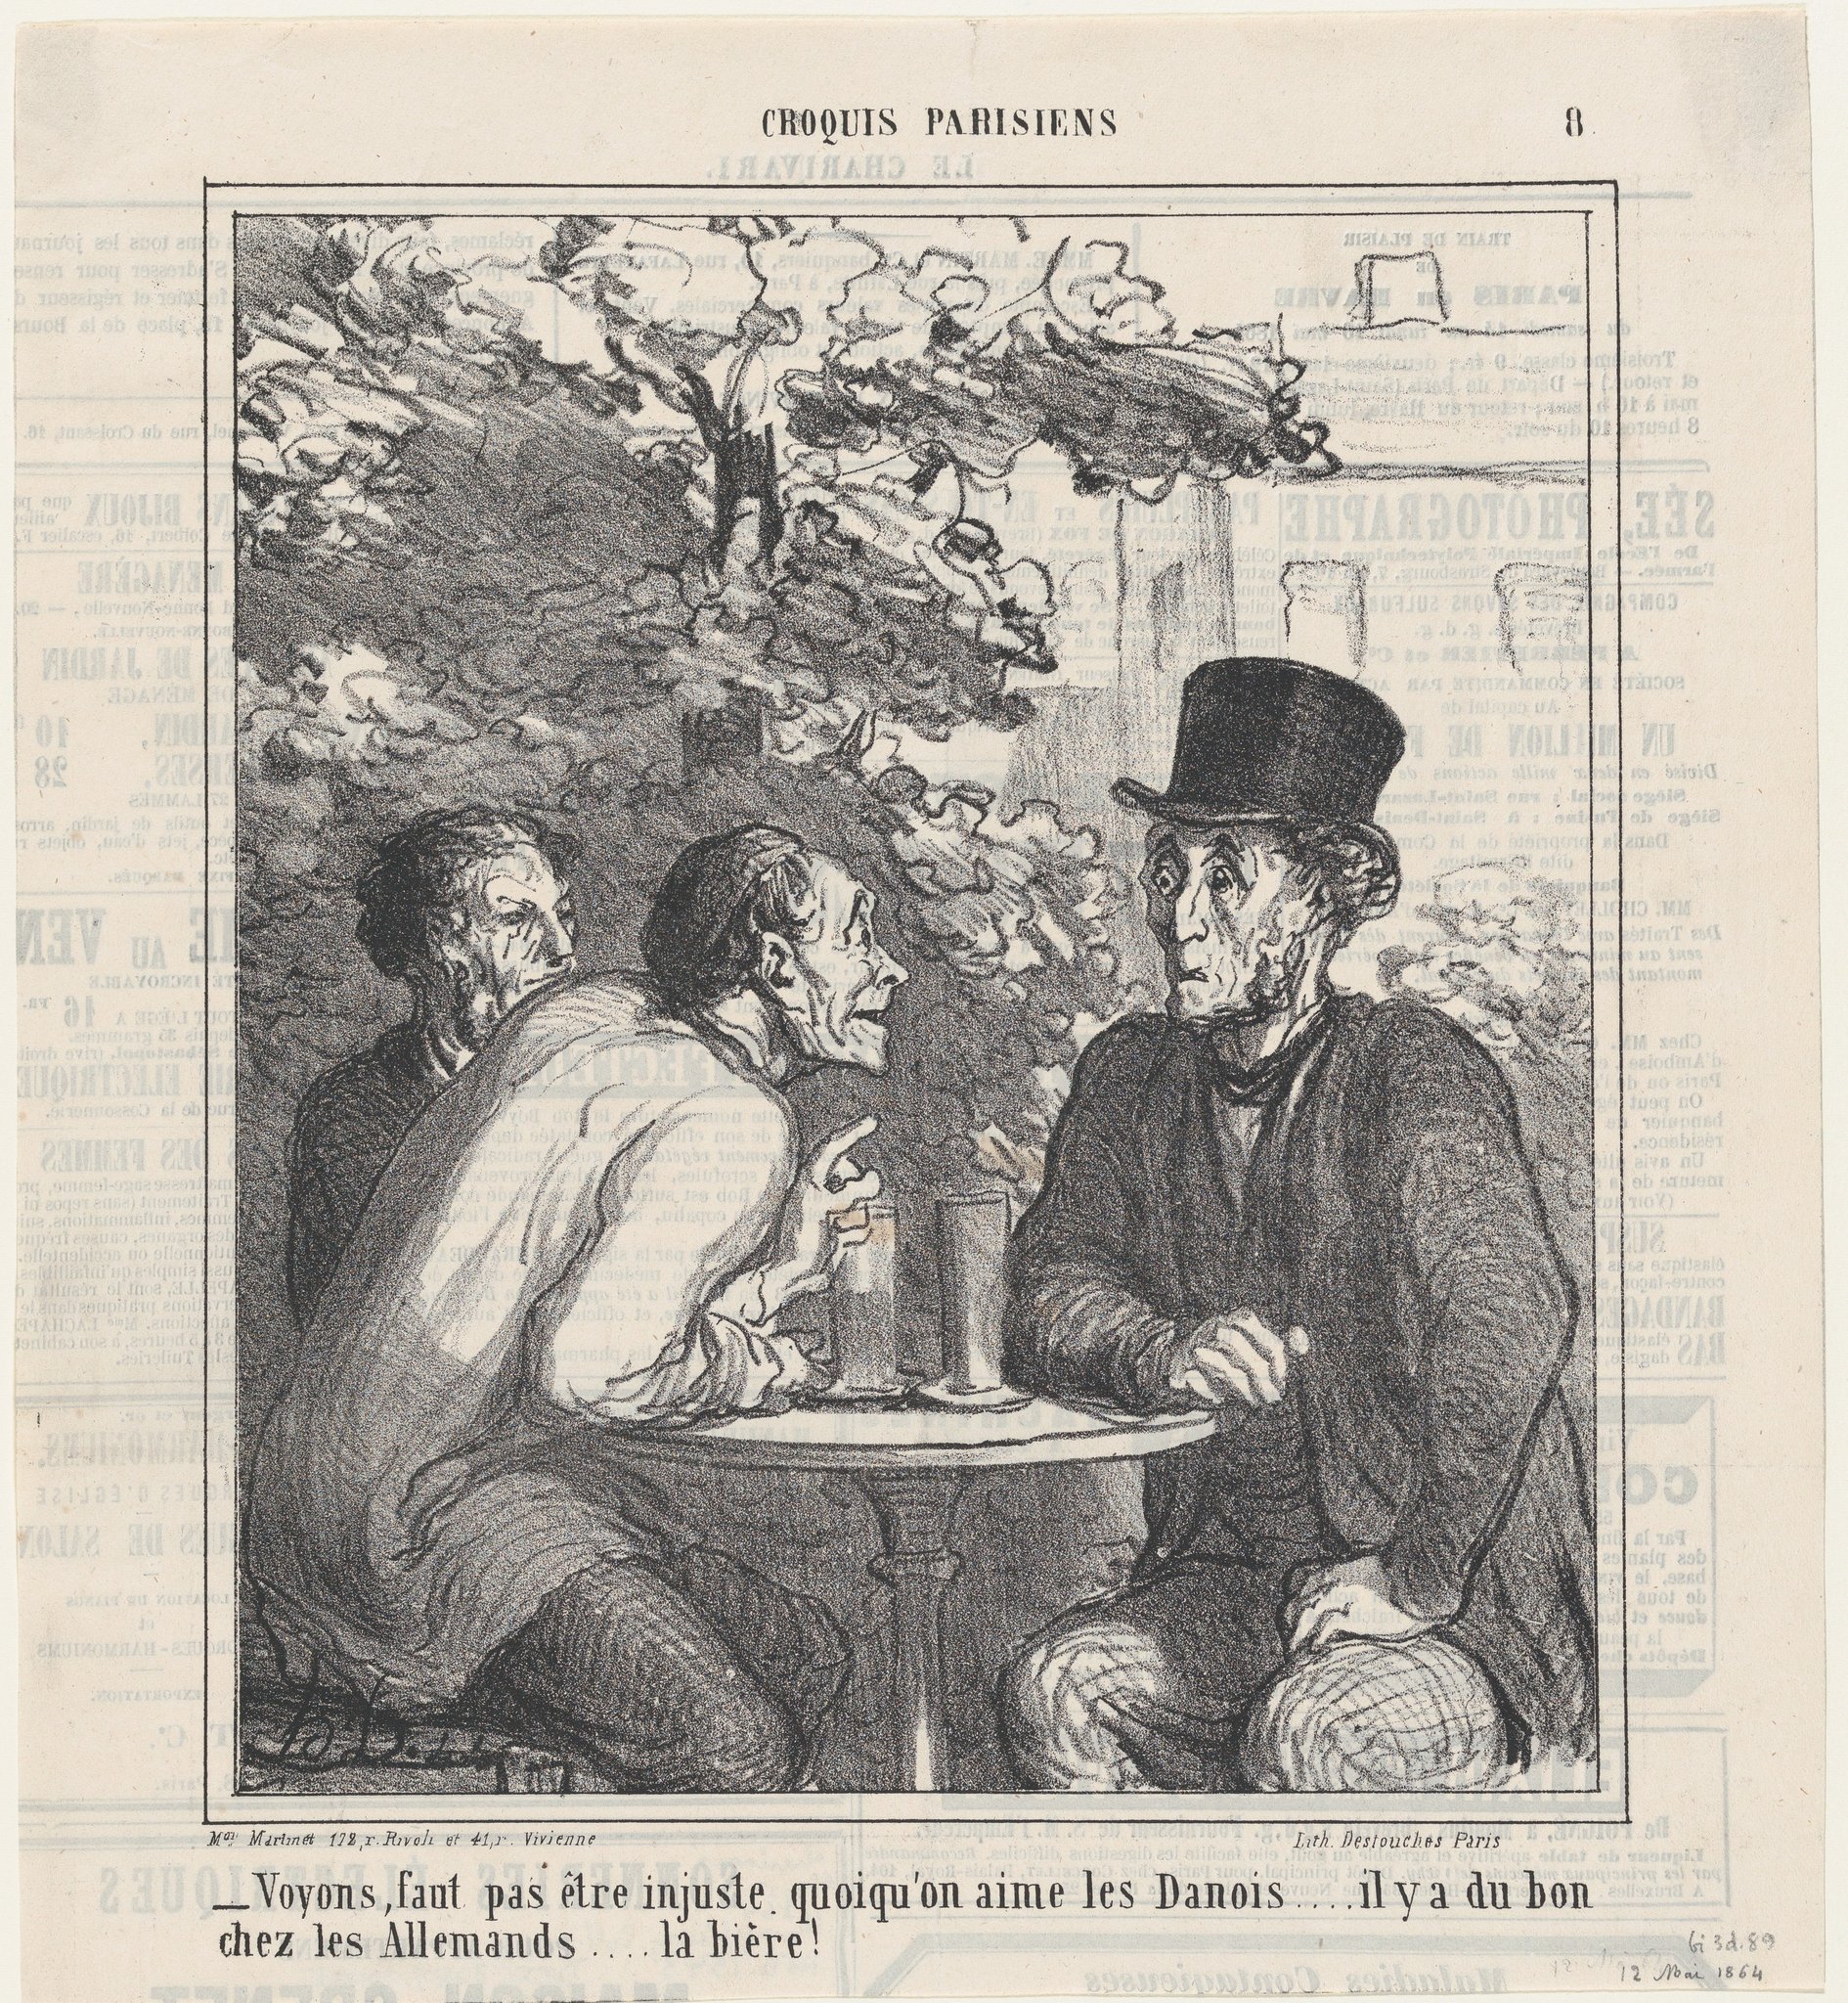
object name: print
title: We shouldn't be unfair..., from 'Parisian sketches,' published in Le Charivari, May 12, 1864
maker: honoré daumier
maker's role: artist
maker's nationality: french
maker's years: 1808-1879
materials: paper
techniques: lithograph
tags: satire,men